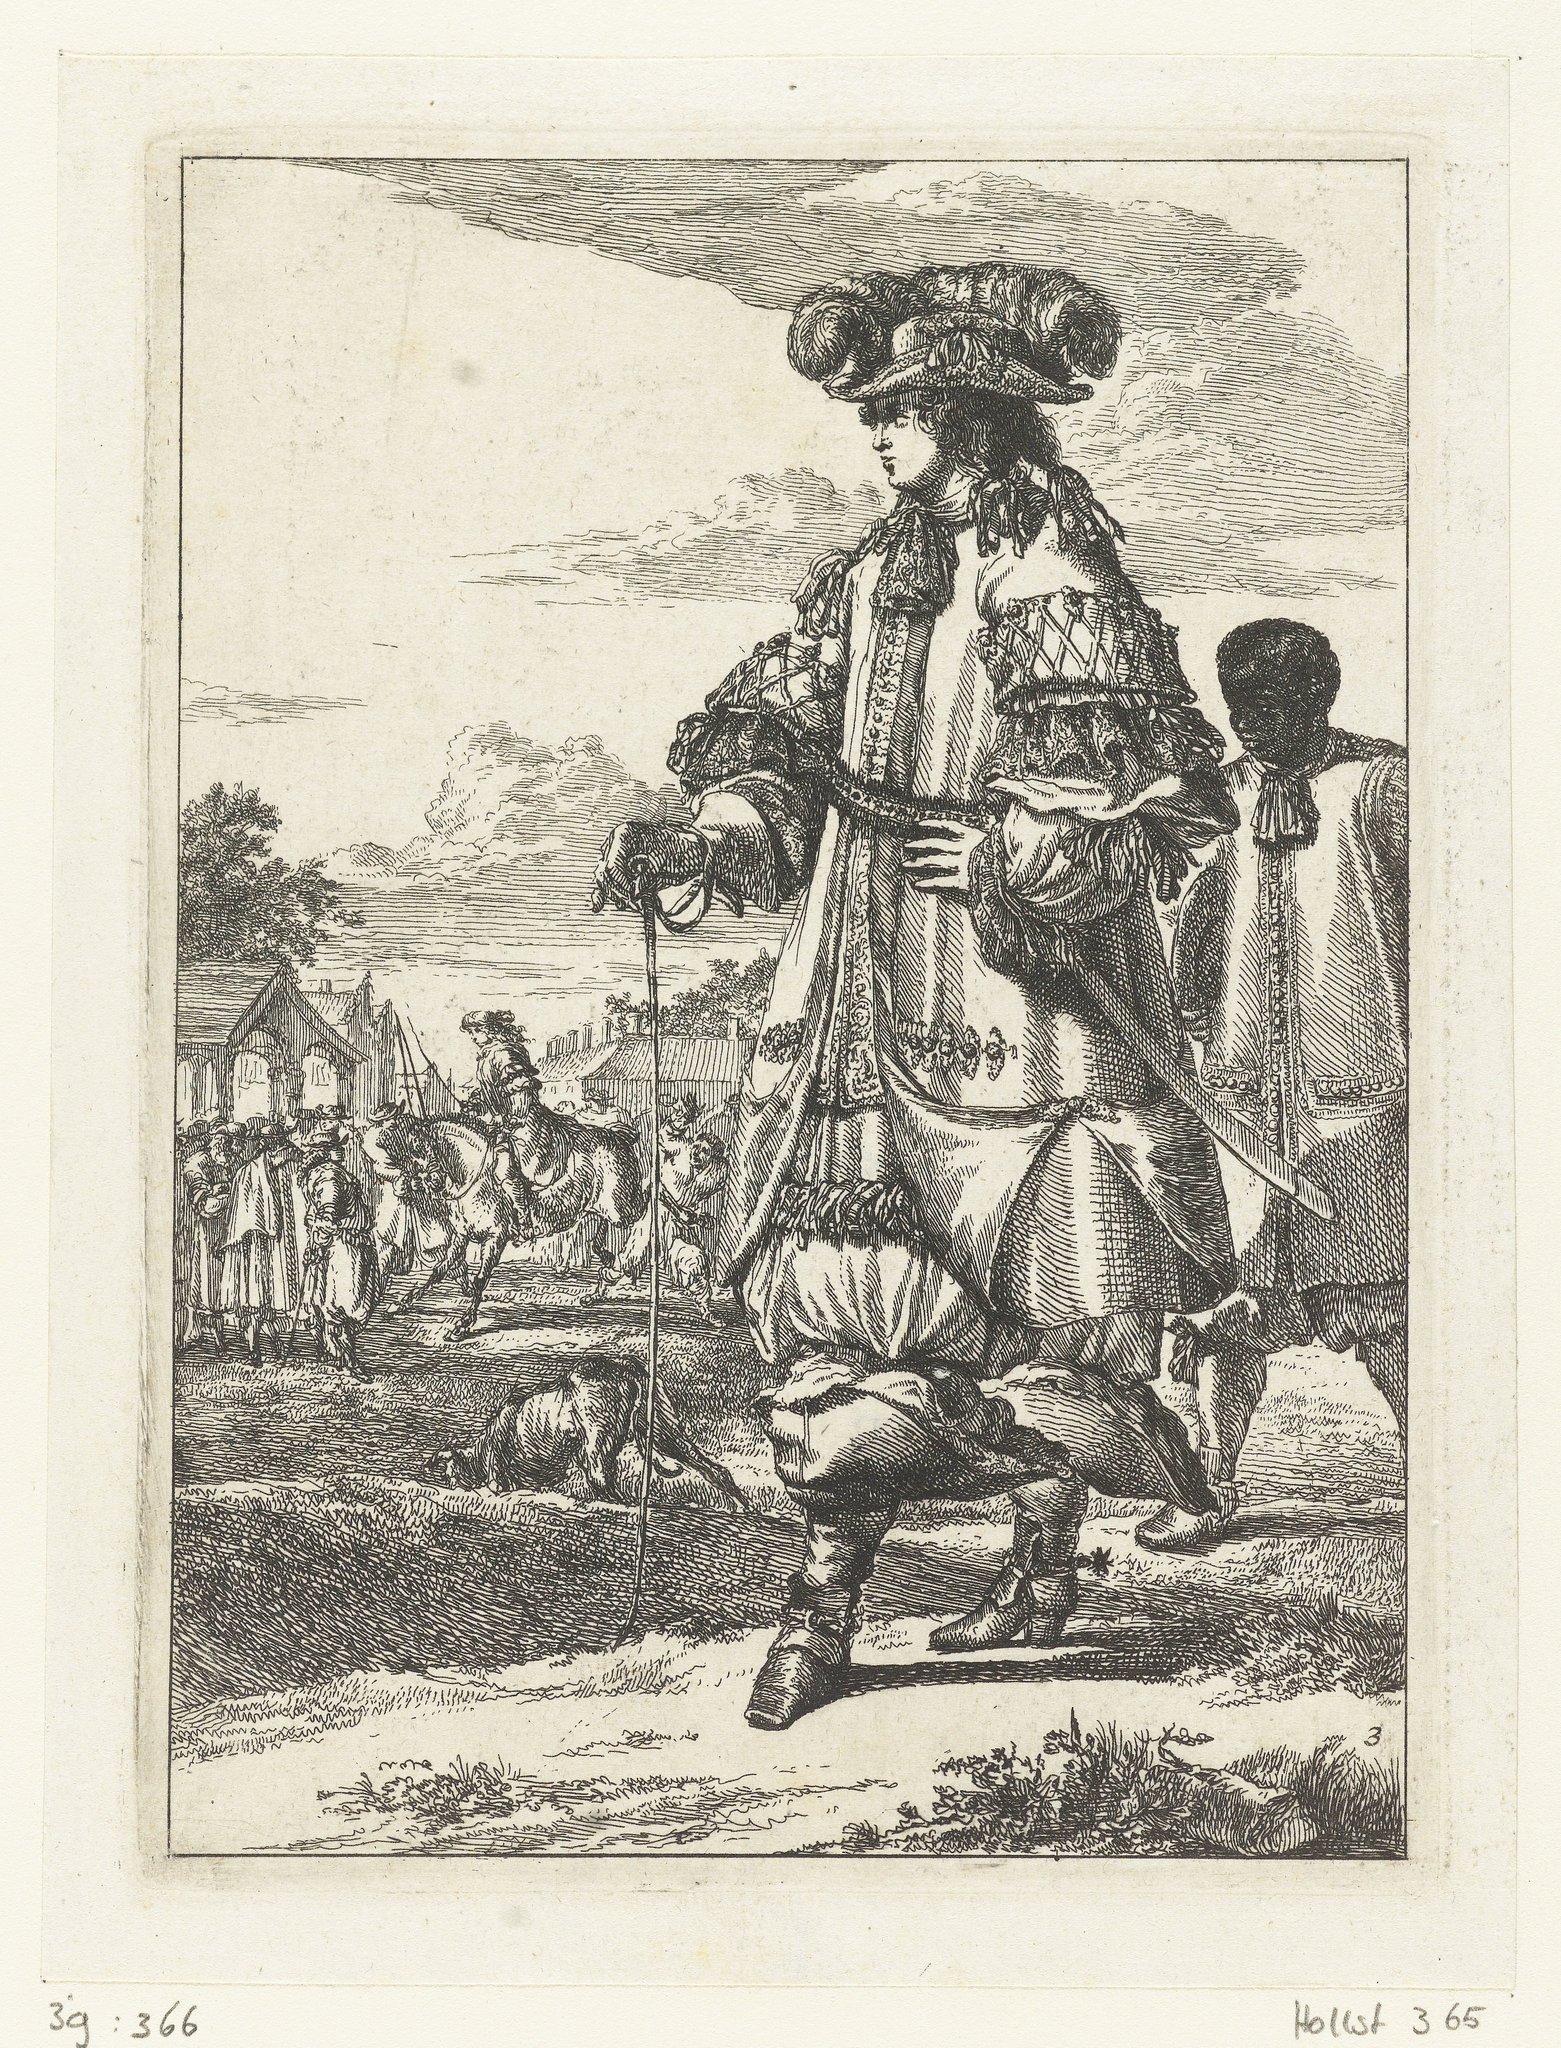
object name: costume print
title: Figures à la Mode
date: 1670-1685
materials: paper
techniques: engraving, etching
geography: netherlands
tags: coat (+ men's clothes), africans, head-gear: hat (+ men's clothes), shoes, sandals (+ men's clothes), trousers, breeches, etc. (breeches) (+ men's clothes), clothes, costume, head-gear: hat (+ feathers used for clothes), walking-stick, staff, cane (+ men's clothes), manservant, footman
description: From the middle of the 17th century fashionable men wore ‘rhinegraves’, extremely full breeches decorated with an ‘apron’ of braids under long fitted coats. The long curly hair, high-heeled shoes, large bands and profusion of buttons and bows amazed many contemporaries. The men in this series by De Hooghe almost seem to succumb to their garments.